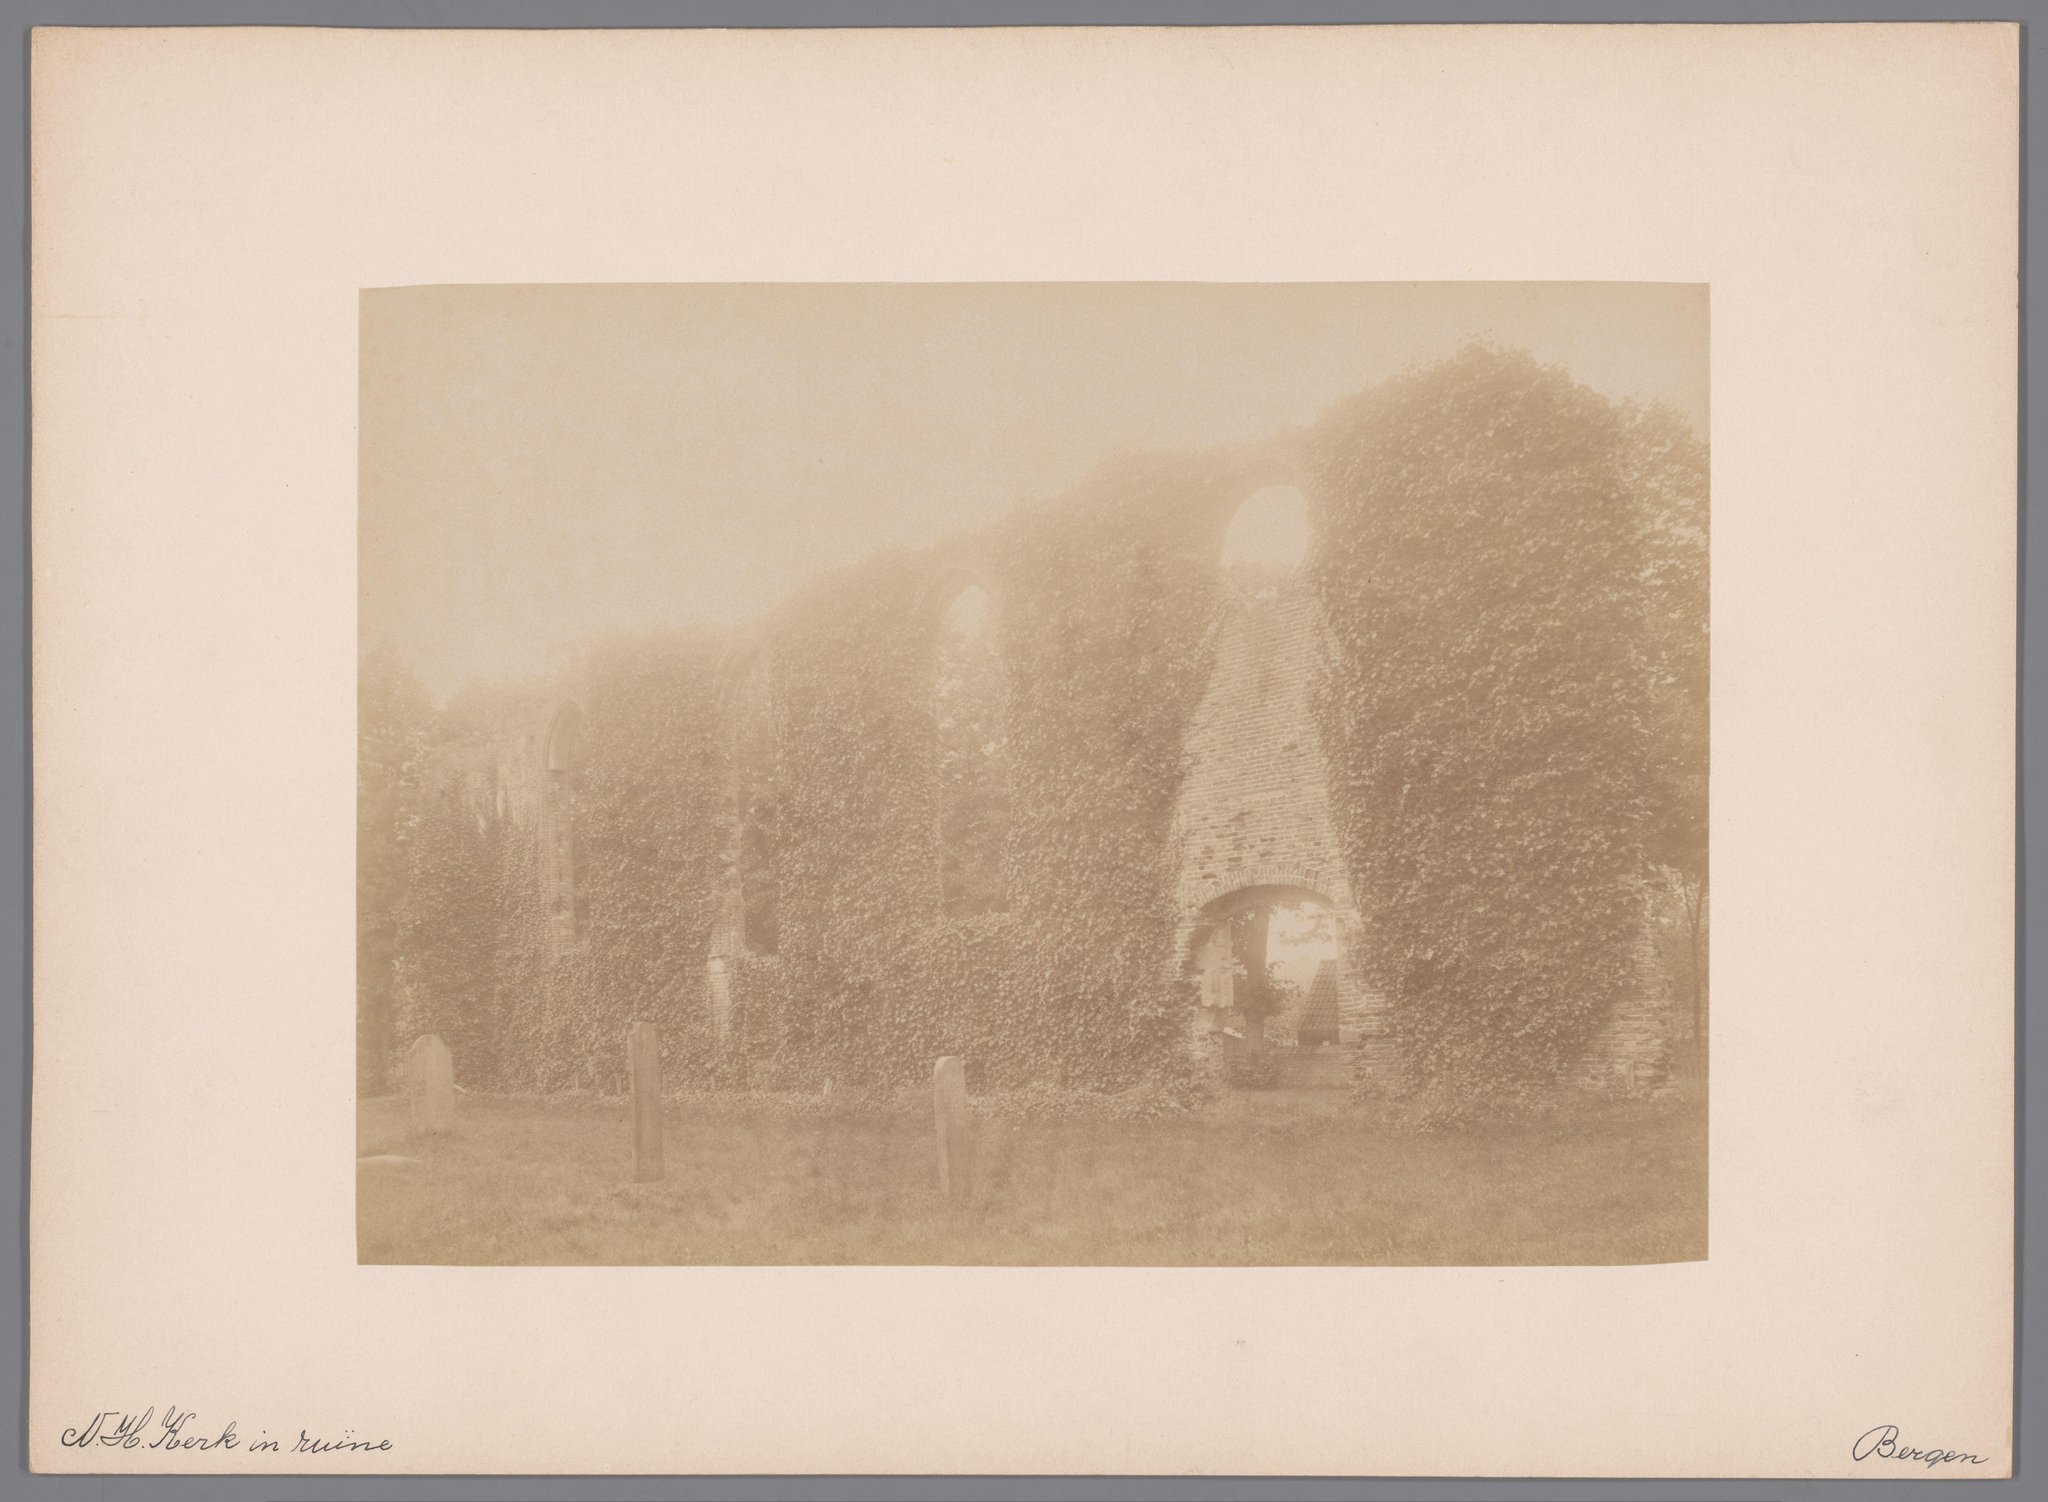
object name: photograph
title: Begroeide muur van de Ruïnekerk te Bergen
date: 1905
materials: cardboard, photographic support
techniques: albumen print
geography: bergen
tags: church (exterior), ruin of church, monastery, etc.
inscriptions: annotation: ‘N.H. Kerk in ruïne/ Bergen’, annotation: ‘Bergen (N.H.)/ Zuidzijde van der noordmuur der voormalige kerk/ sept 1905’